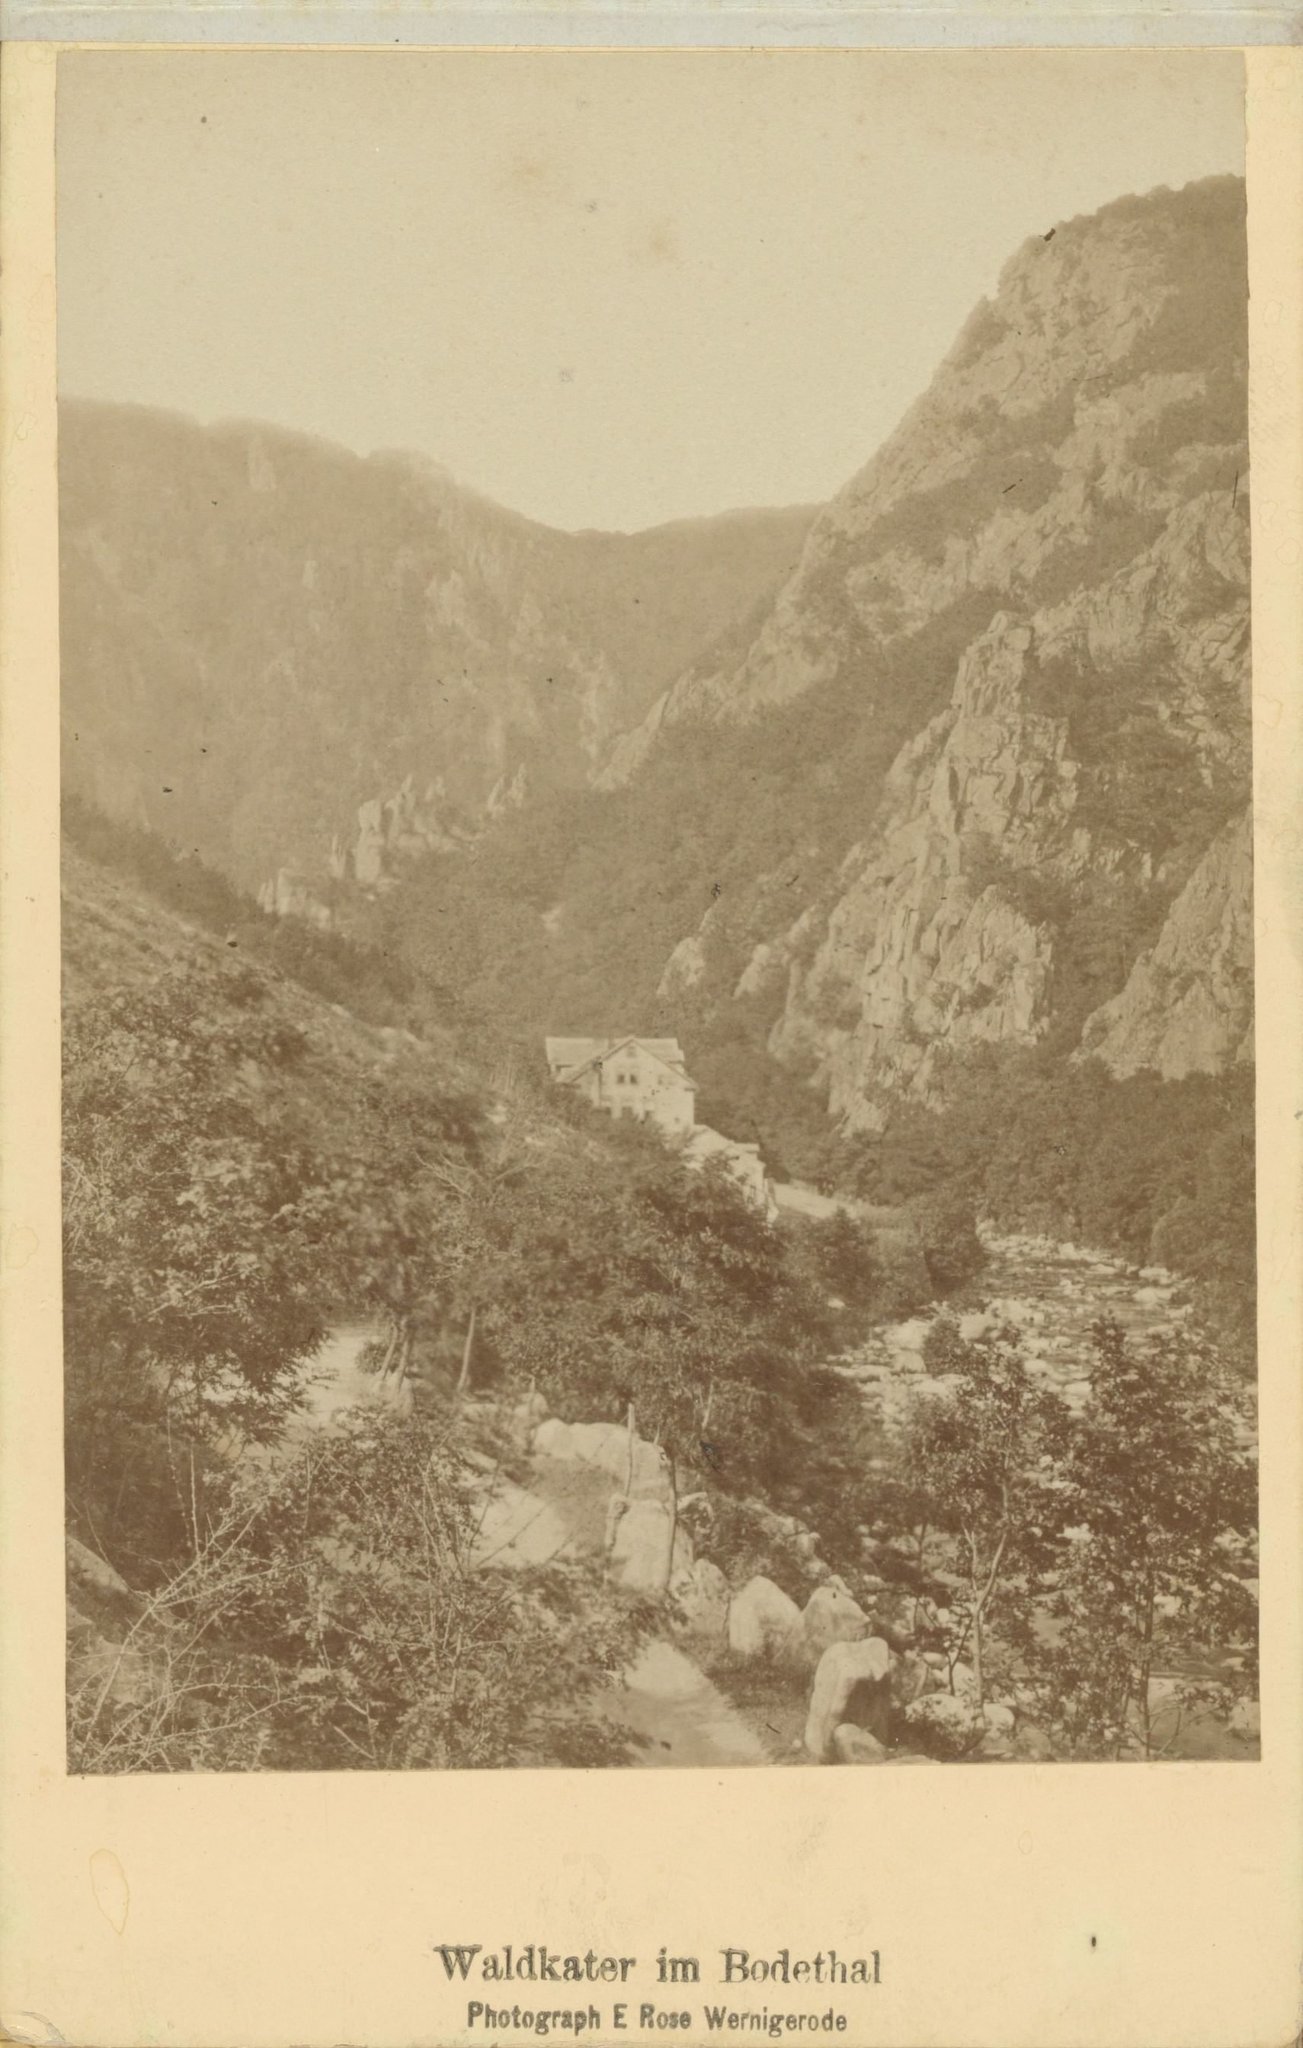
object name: photograph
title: Waldkater im Bodethal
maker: e. rose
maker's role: fotograaf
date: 1870-1890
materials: cardboard, paper, photographic support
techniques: albumen print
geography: bodenthal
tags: ravine, chasm, abyss, canyon, travelling; tourism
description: Onderdeel van Album met 38 foto's van een reis door de Harz.